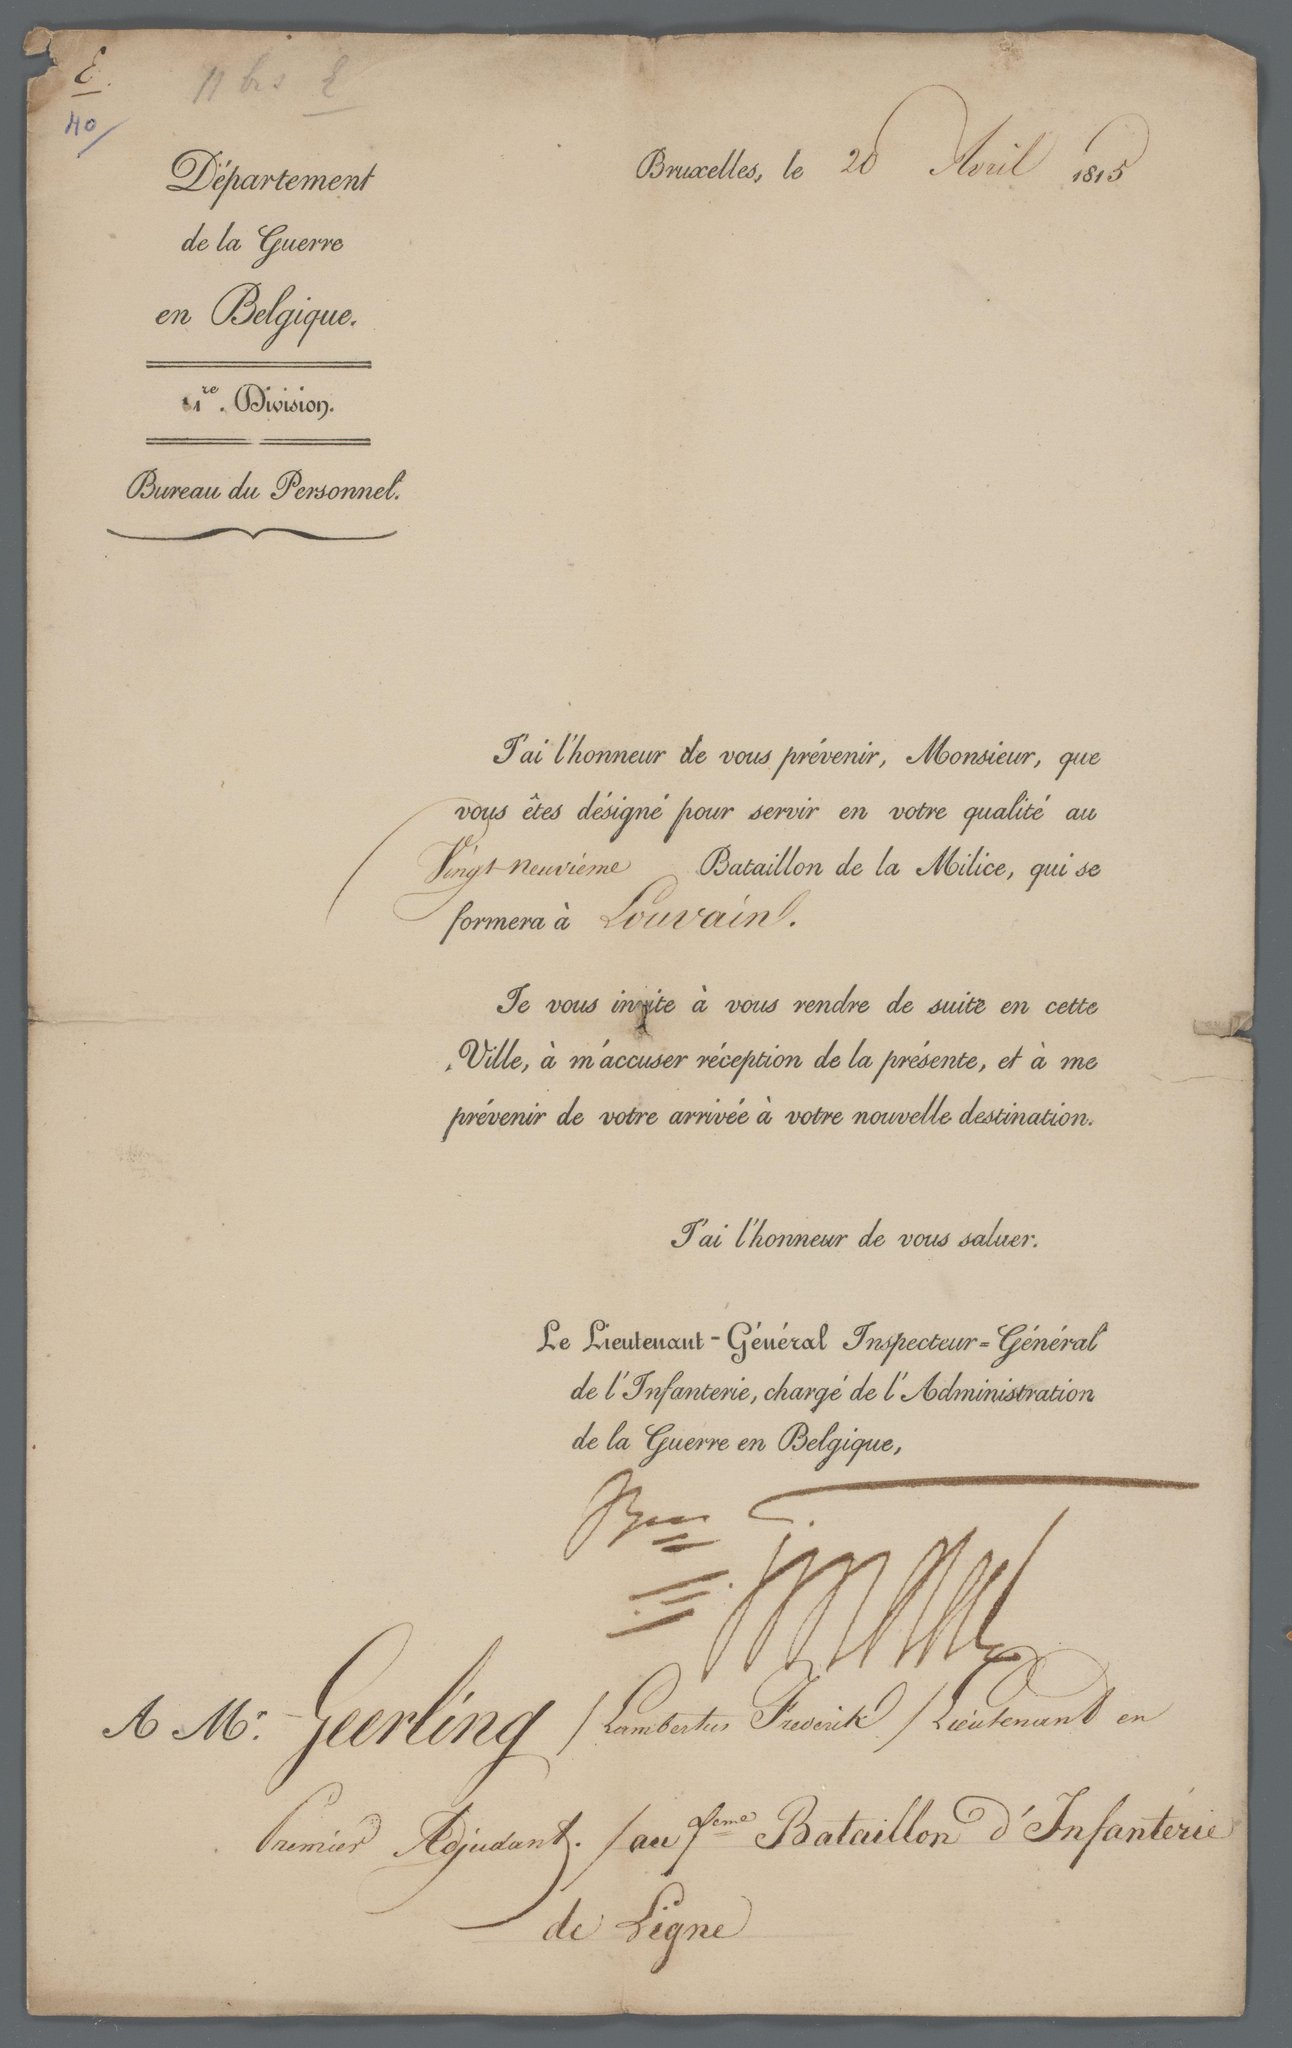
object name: bevel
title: Militaire instructie aan Lambertus Frederik Geerling, 20 april 1815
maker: Anonymous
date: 1815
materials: ink, paper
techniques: engraving, pen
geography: brussels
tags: militair, lambertus frederik geerling, slag bij waterloo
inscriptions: date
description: MIlitaire instructie gedateerd Brussel 20 april 1815 aan Lambertus Frederik Geerling (de vader van Frederik Lambertus Geerling), adjudant bij de 7e bataljon infanterie, om zich te voegen bij de 29e bataljon militie te Leuven.